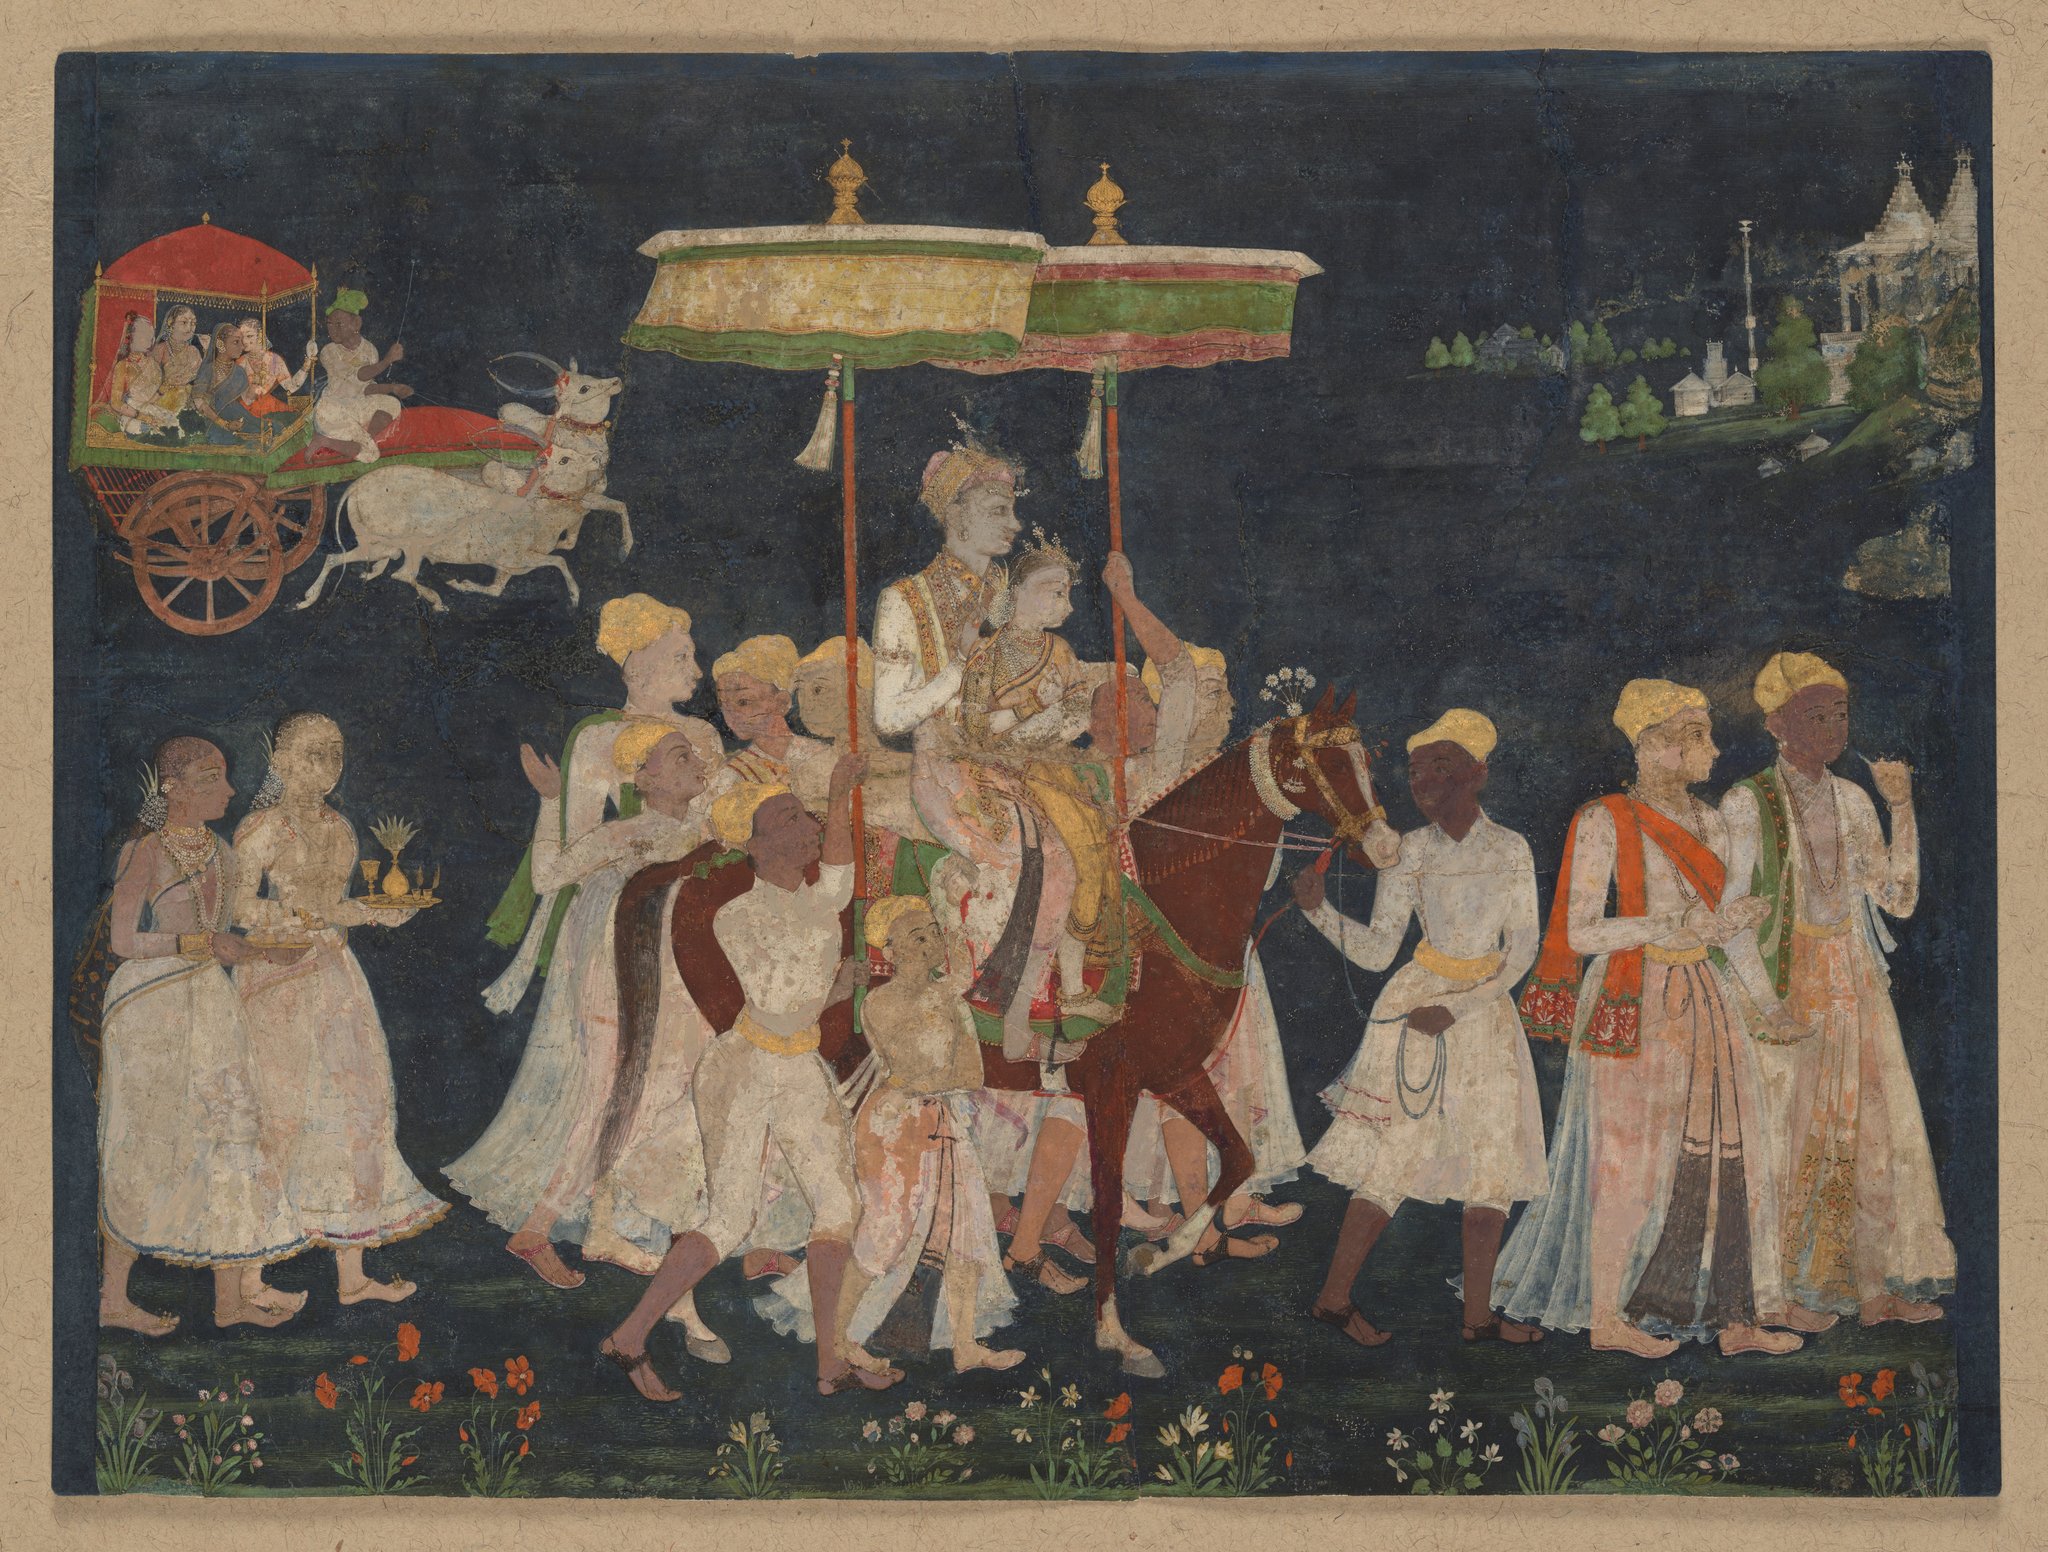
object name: illustrated album leaf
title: Wedding Procession of Sultan Muhammad Quli Qutb Shah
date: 1650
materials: gold, paper, watercolor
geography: india